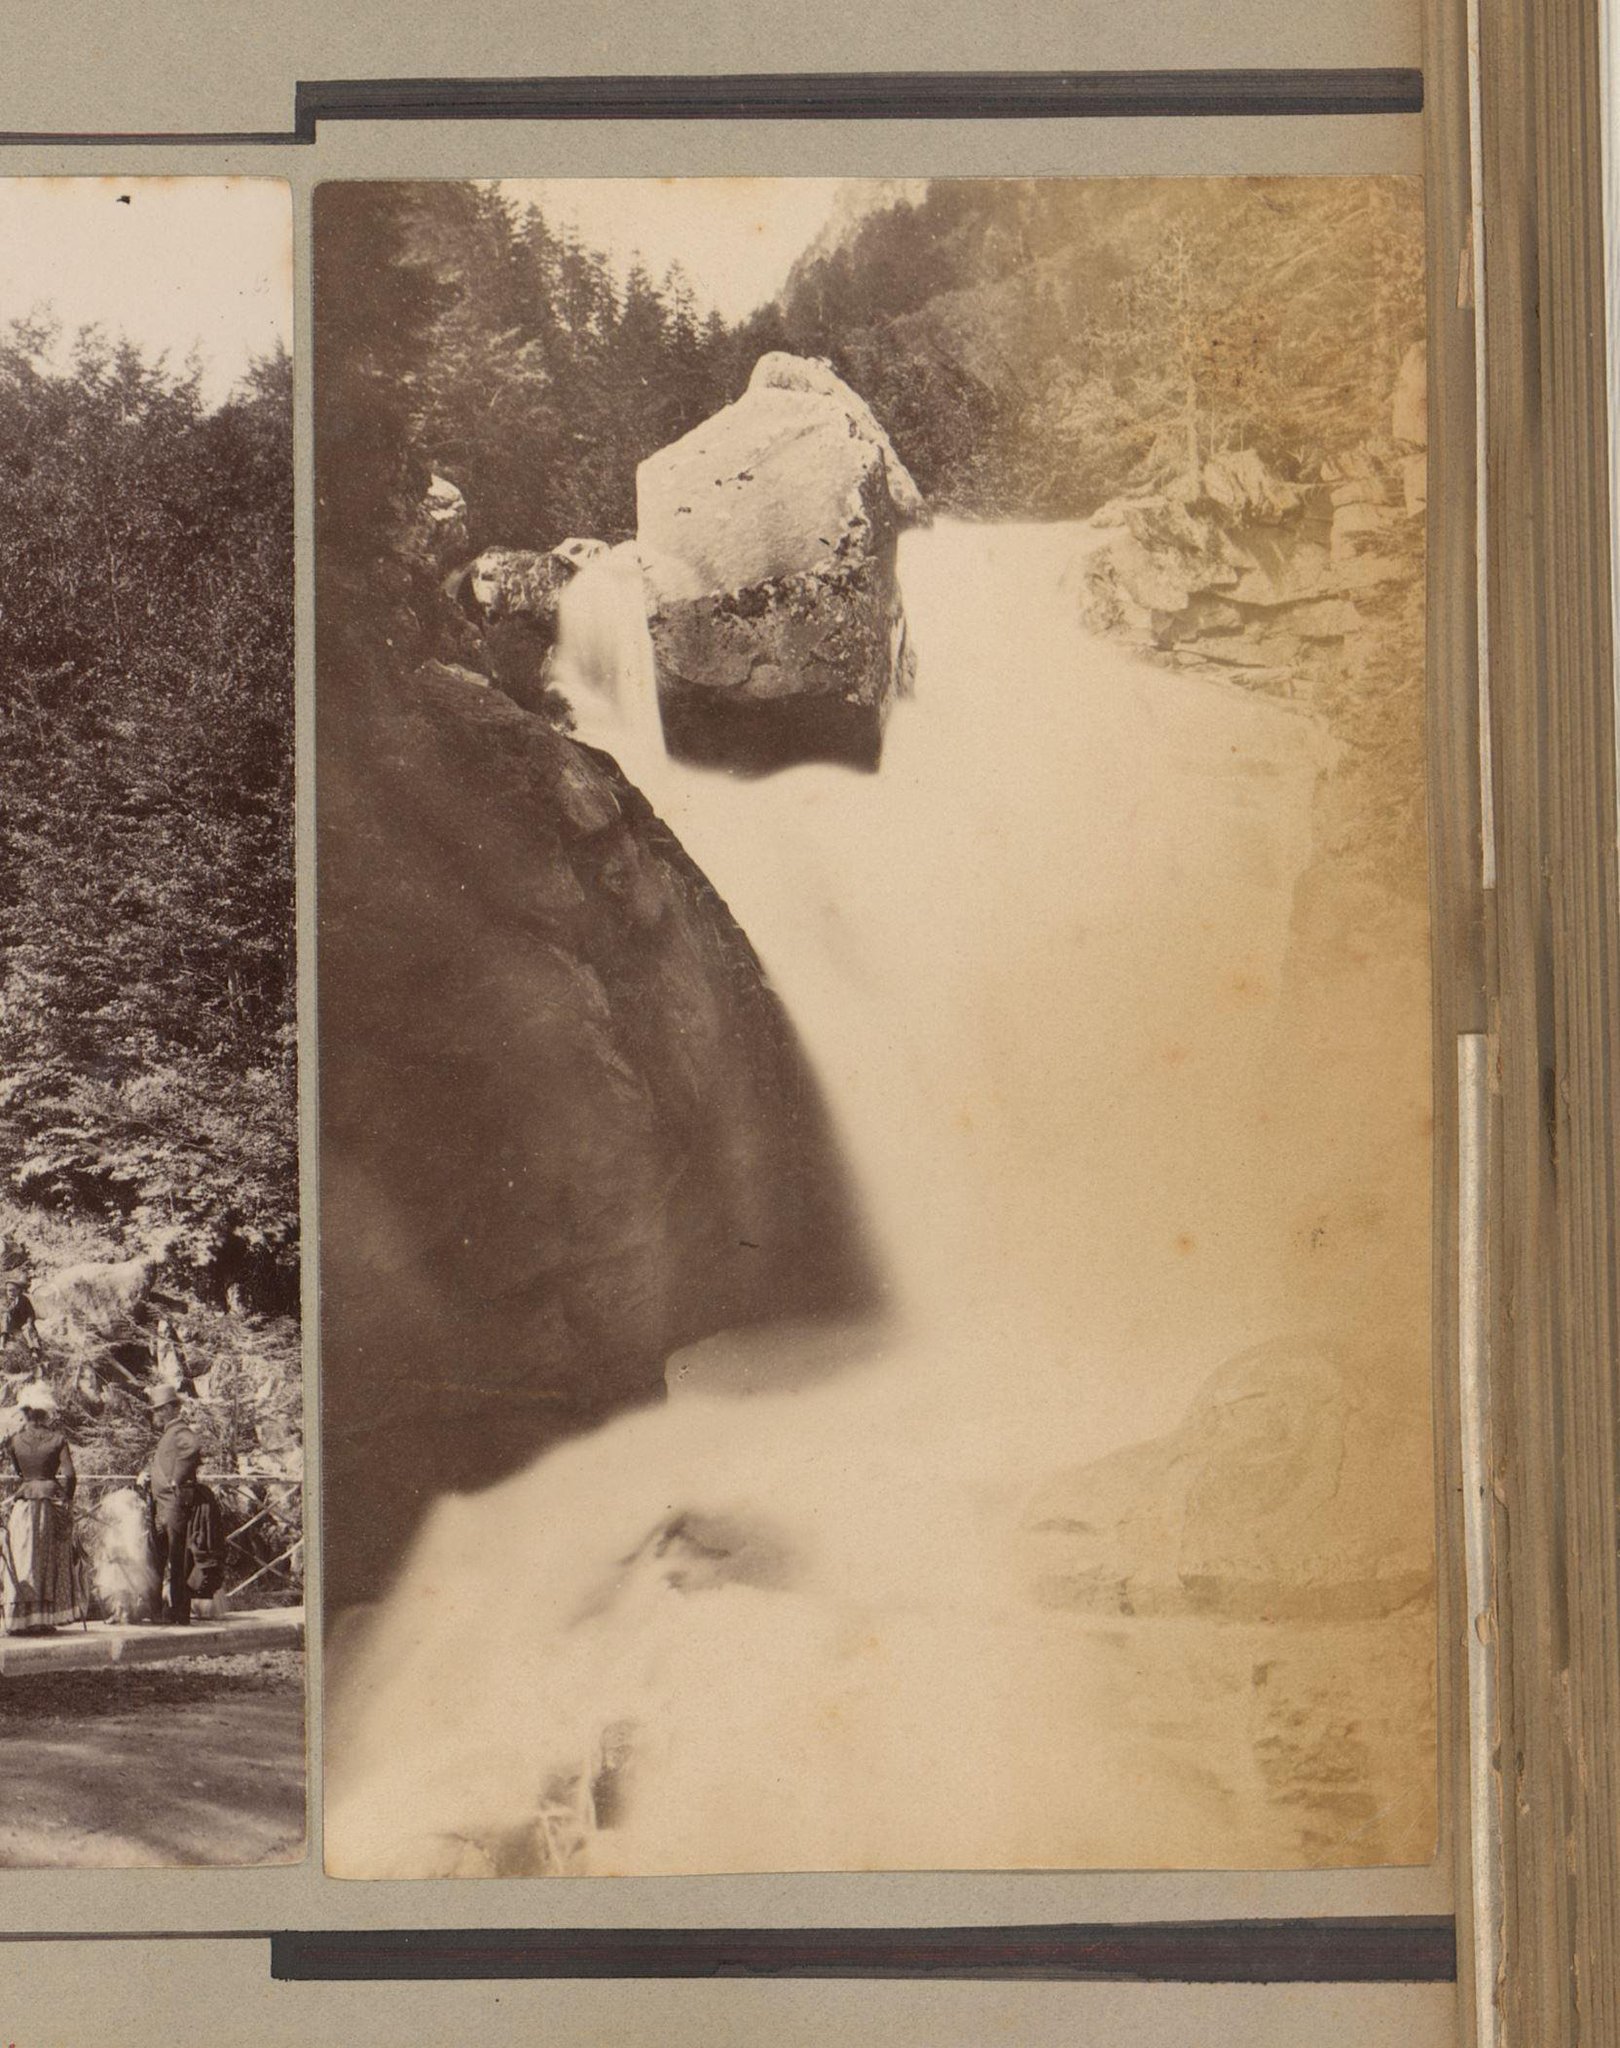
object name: photograph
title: Waterval bij Gripp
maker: Anonymous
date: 1880-1910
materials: photographic support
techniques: albumen print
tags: waterfall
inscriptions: annotation: ‘Cascades du Gripp’